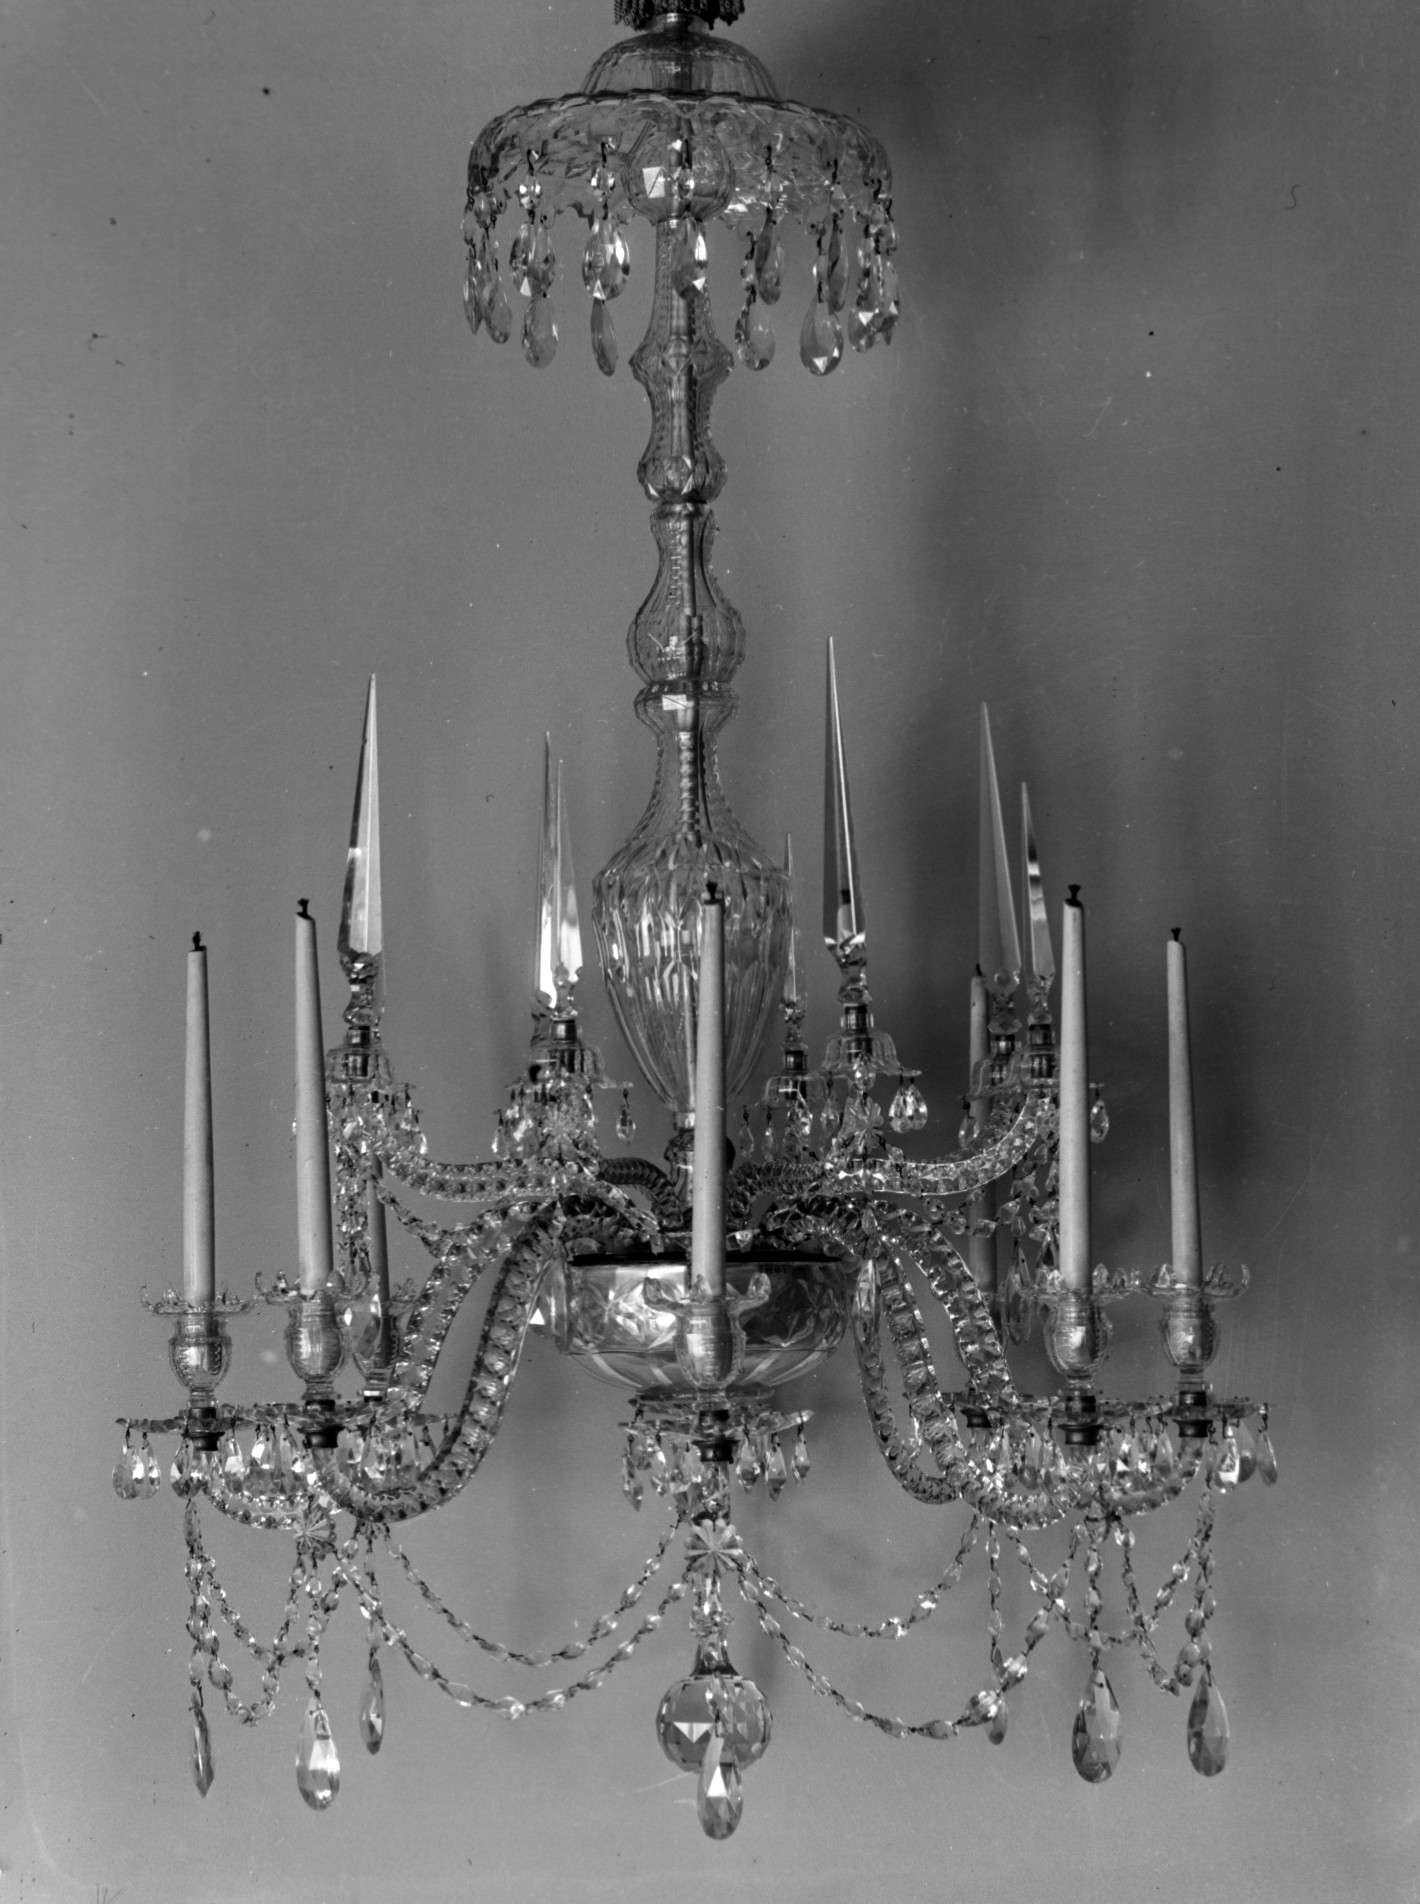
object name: chandelier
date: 1701-1800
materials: glass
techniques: cutting